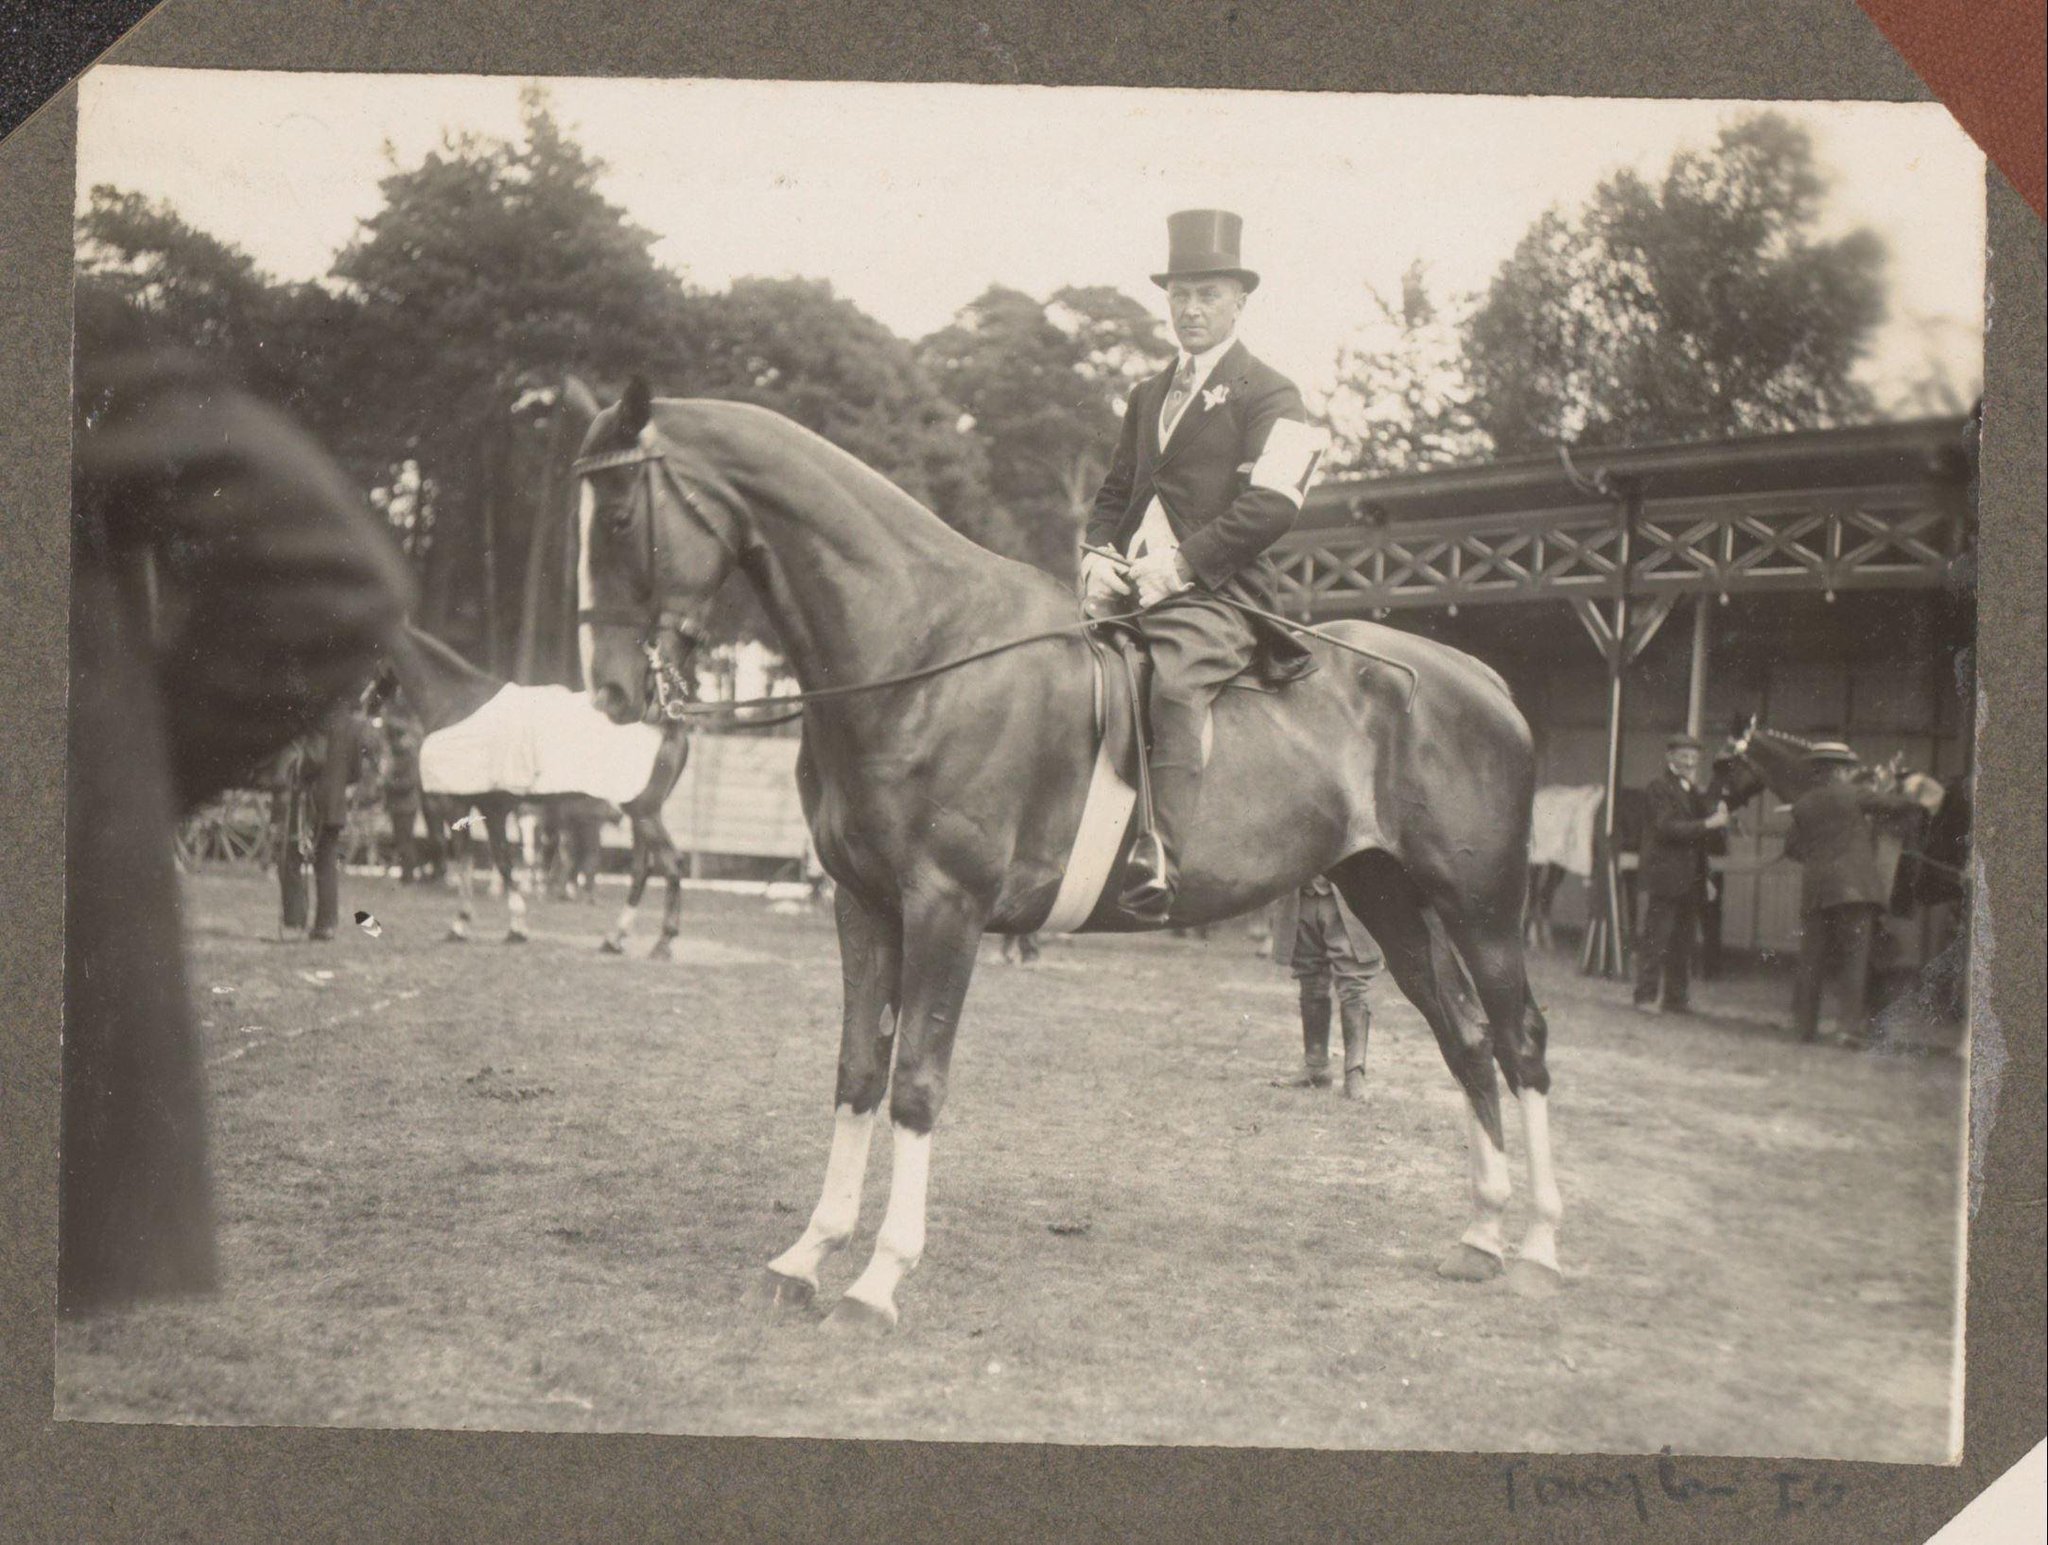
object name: photograph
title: Ruitertafereel op Koninklijke Houtvesterij Het Loo: man te paard op een grasveld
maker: Anonymous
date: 1900-1925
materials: photographic support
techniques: gelatin silver print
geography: het loo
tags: riding a horse, ass, or mule; rider, horseman, hunting, chase, hunting-ground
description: Onderdeel van Fotoalbum van de heer Brams, opperhoutvester van koningin Wilhelmina op Koninklijke Houtvesterij Het Loo.